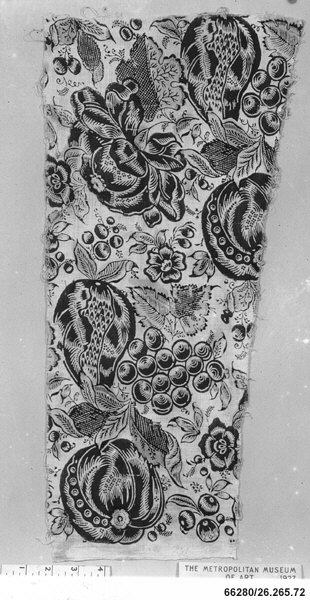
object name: piece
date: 1734-1766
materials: linen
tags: fruit,flowers,leaves